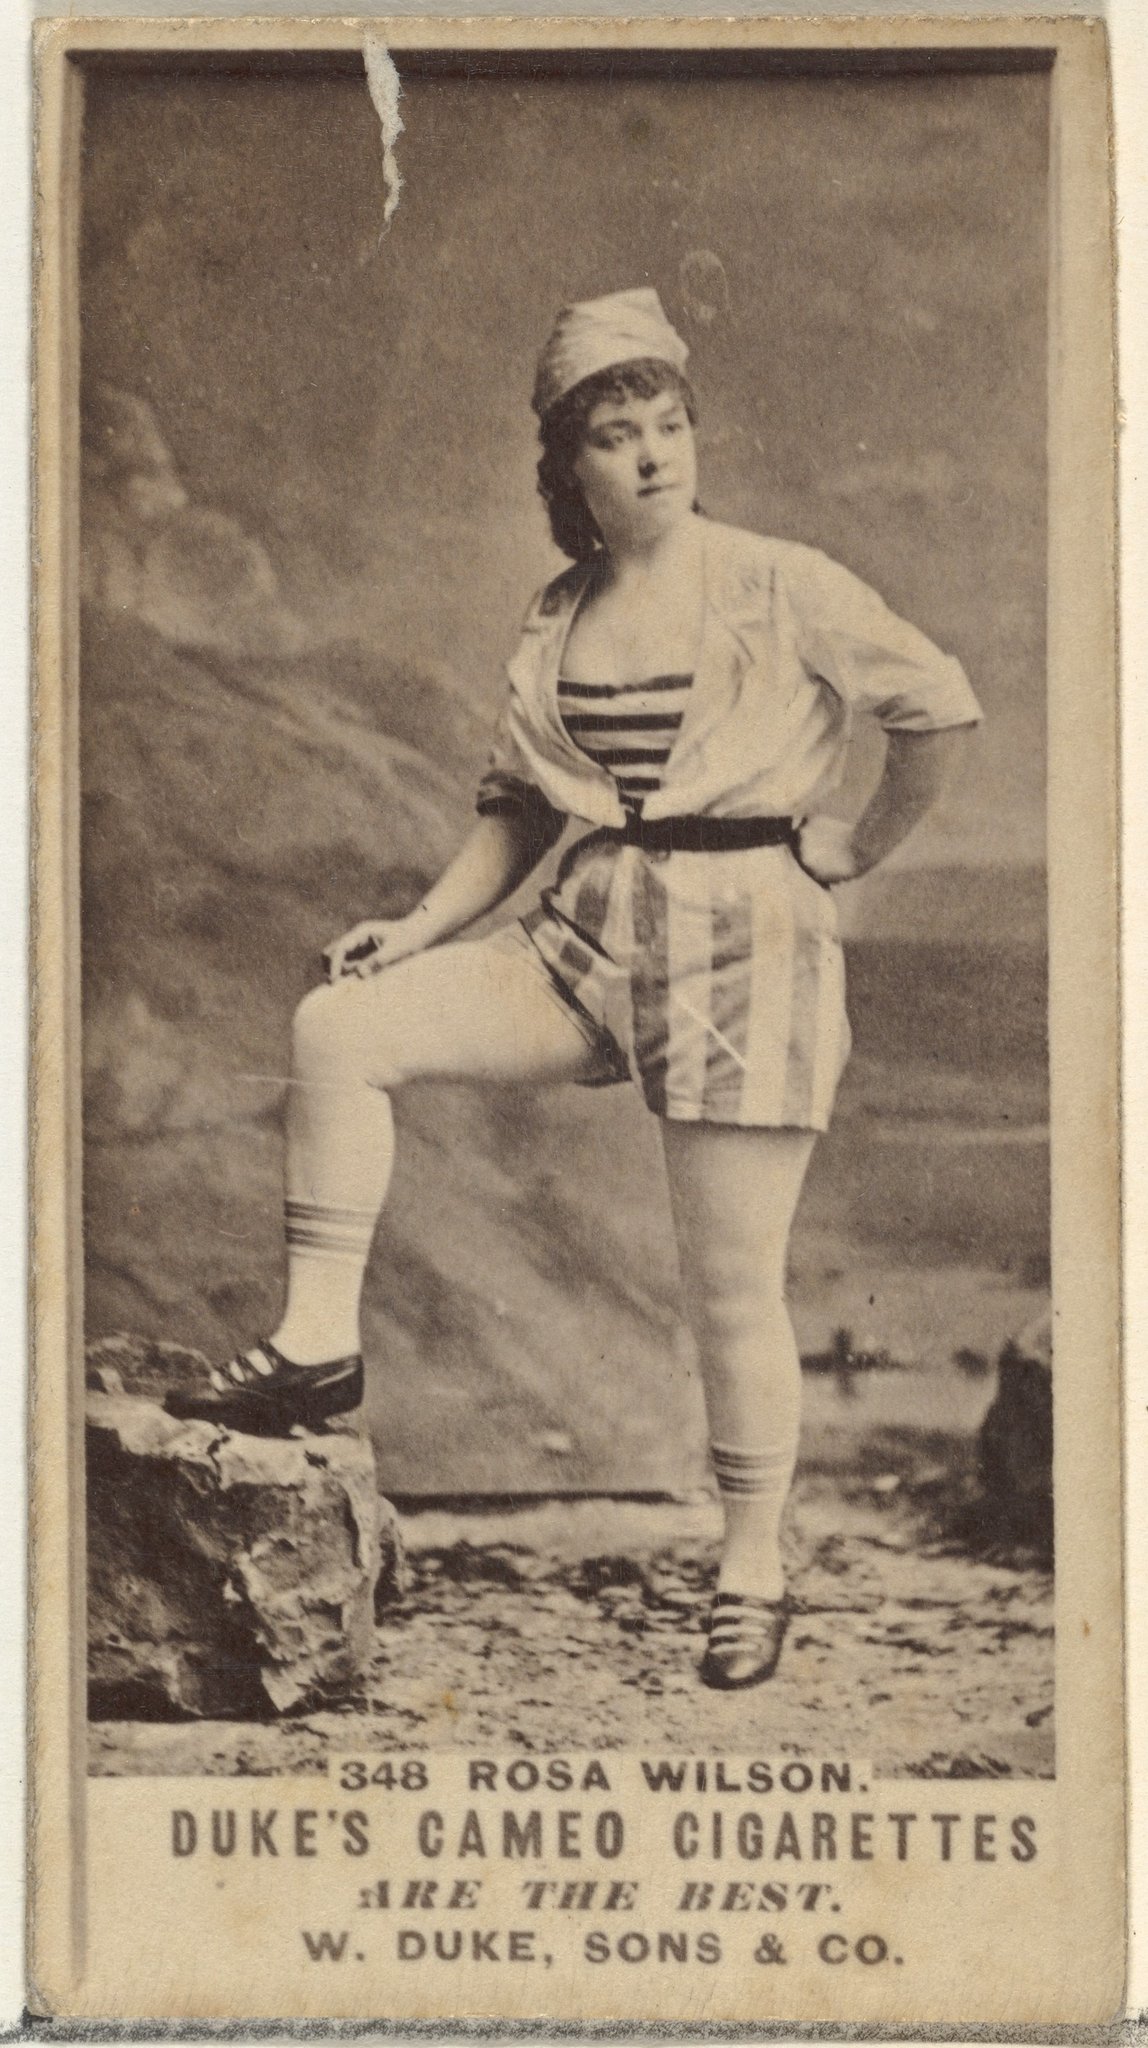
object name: photograph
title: Card Number 348, Rosa Wilson, from the Actors and Actresses series (N145-5) issued by Duke Sons & Co. to promote Cameo Cigarettes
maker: w. duke, sons & co.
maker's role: publisher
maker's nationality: american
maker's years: 1870-1920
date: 1880-1889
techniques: albumen silver print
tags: portraits,women,actresses